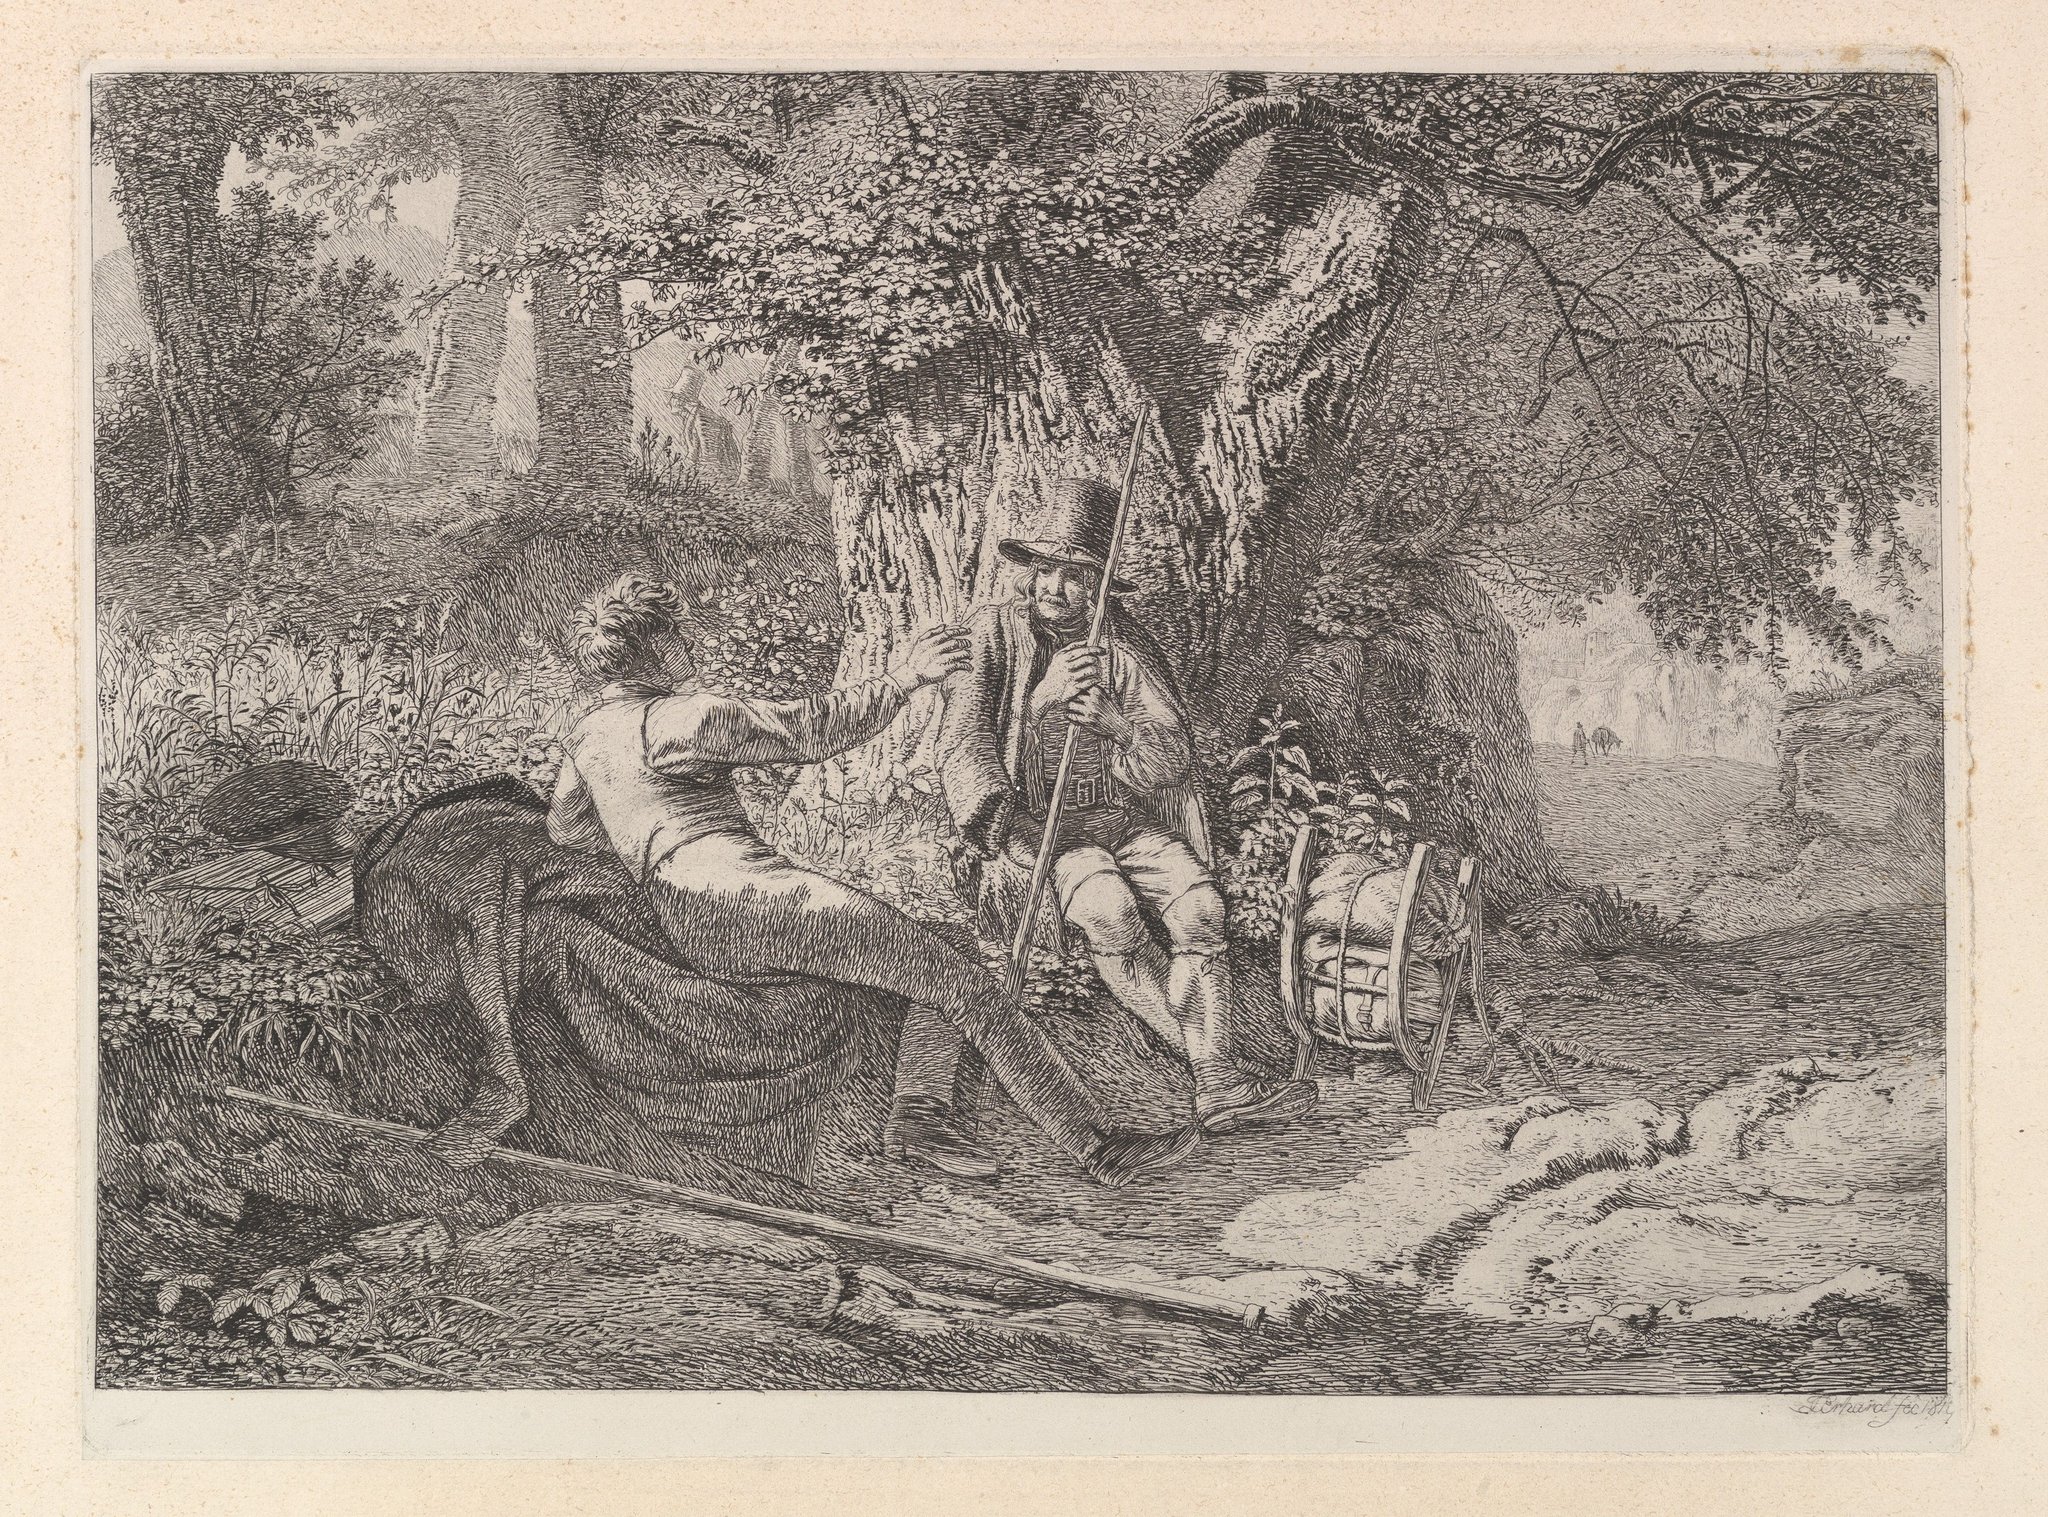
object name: print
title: The Artist, Resting with his Guide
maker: johann christoph erhard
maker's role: artist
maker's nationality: german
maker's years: 1795-1822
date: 1819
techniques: etching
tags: men,trees